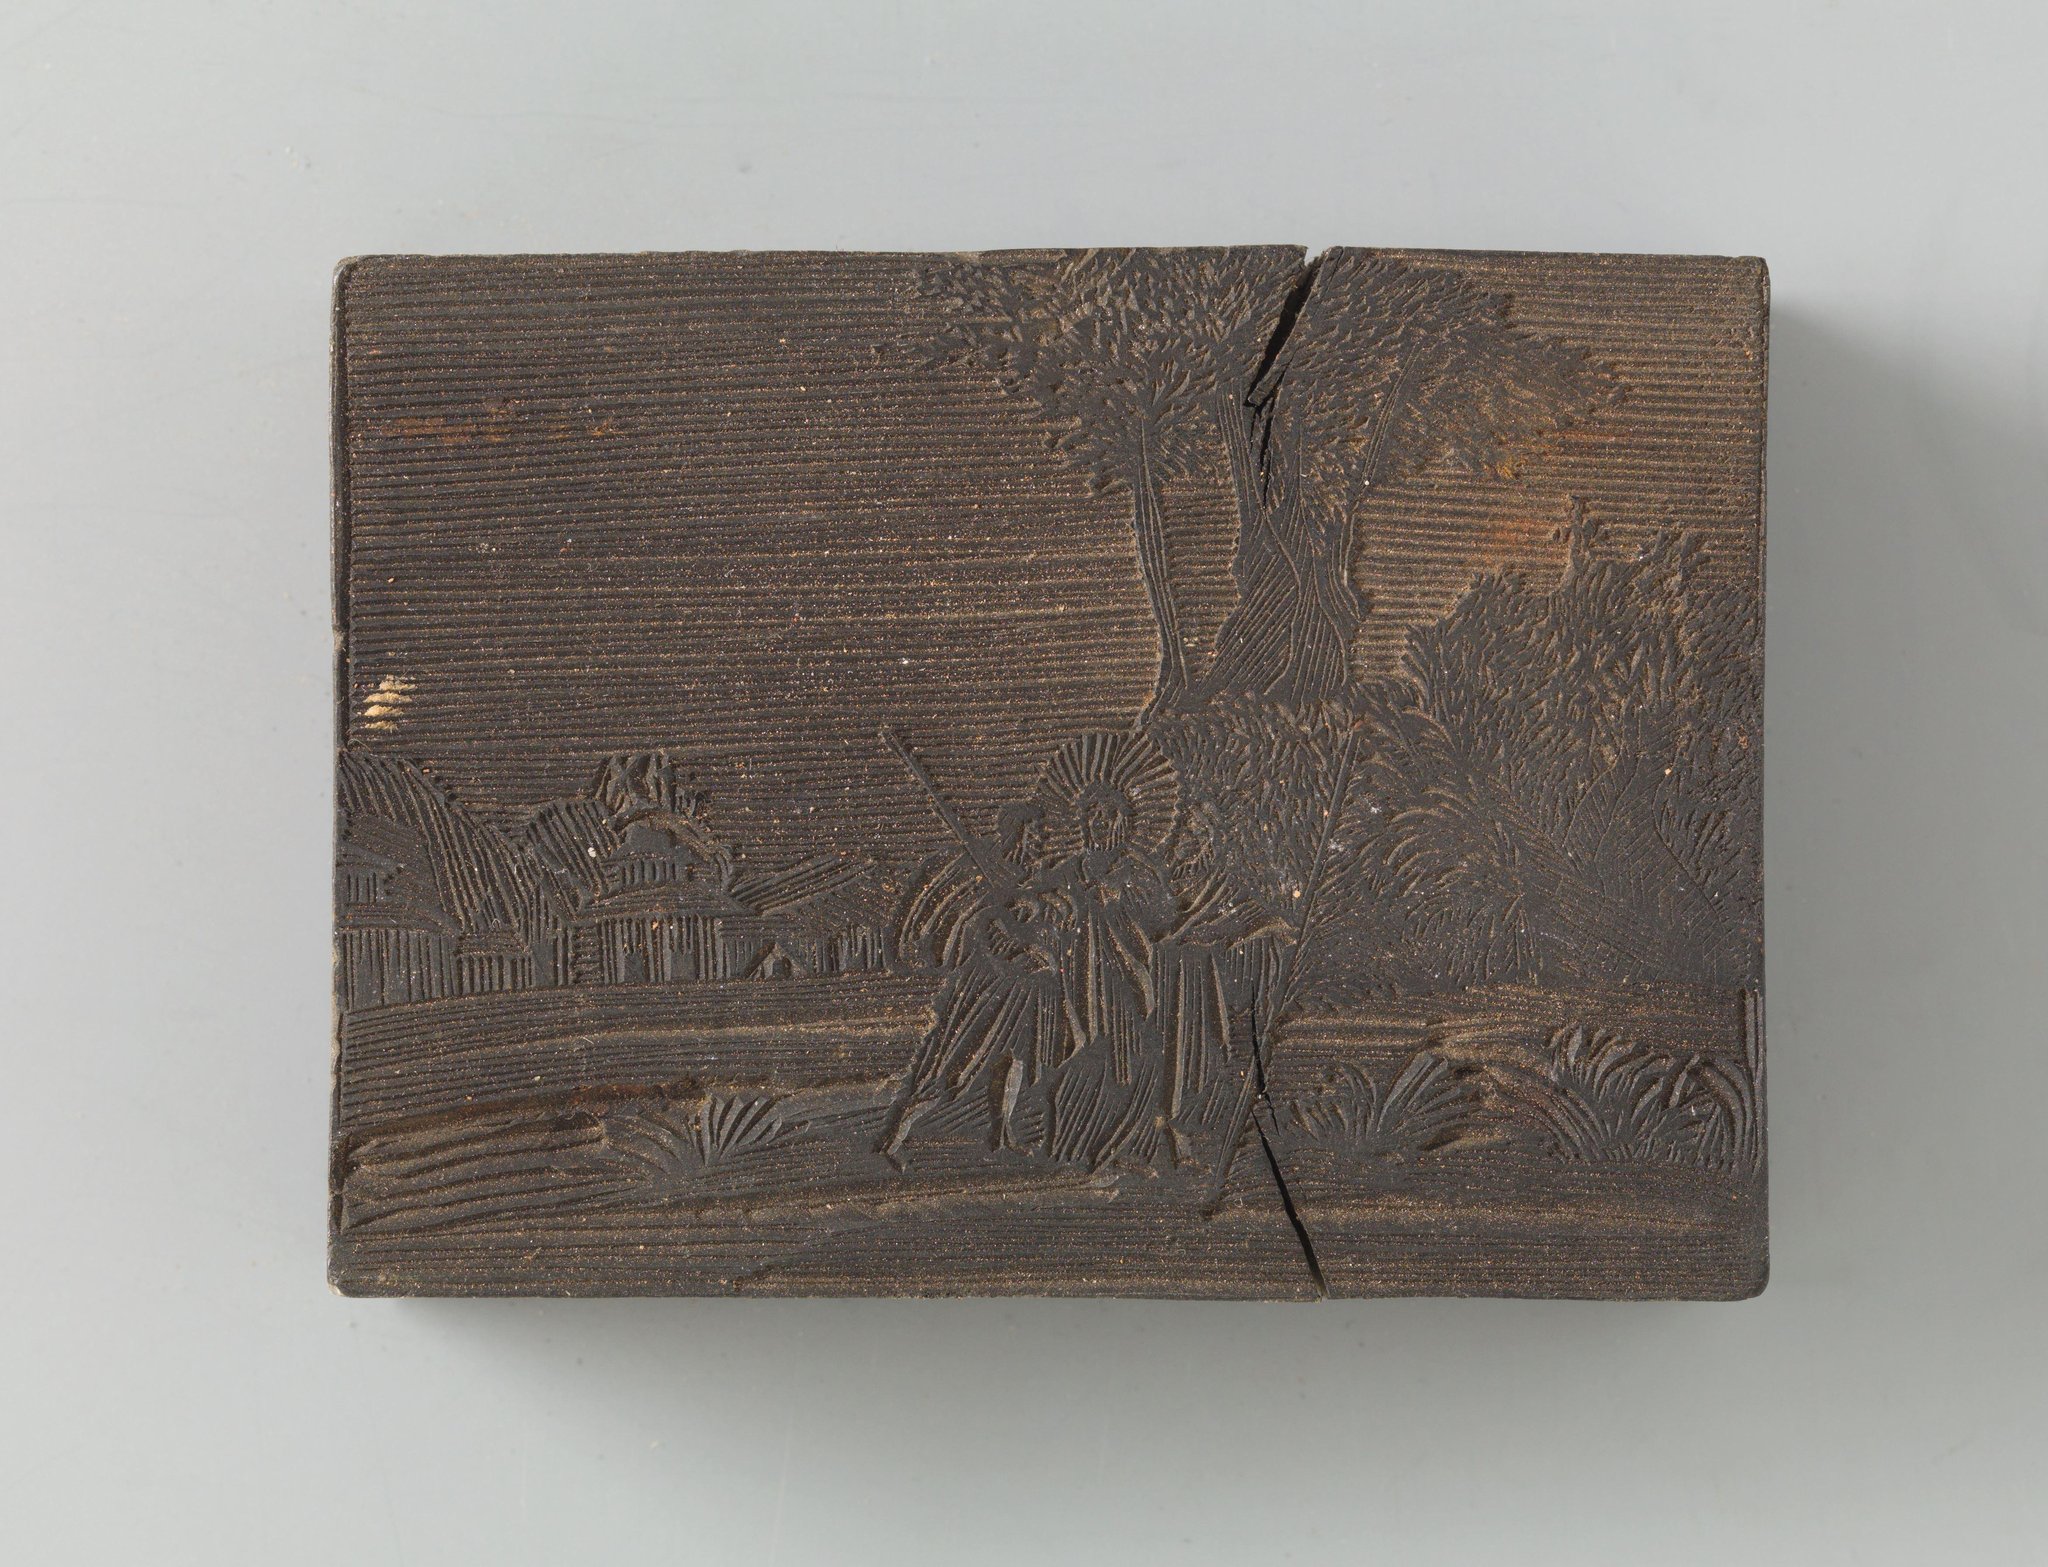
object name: wood block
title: Bijbel-illustraties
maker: Anonymous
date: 1550-1699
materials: wood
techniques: woodcut